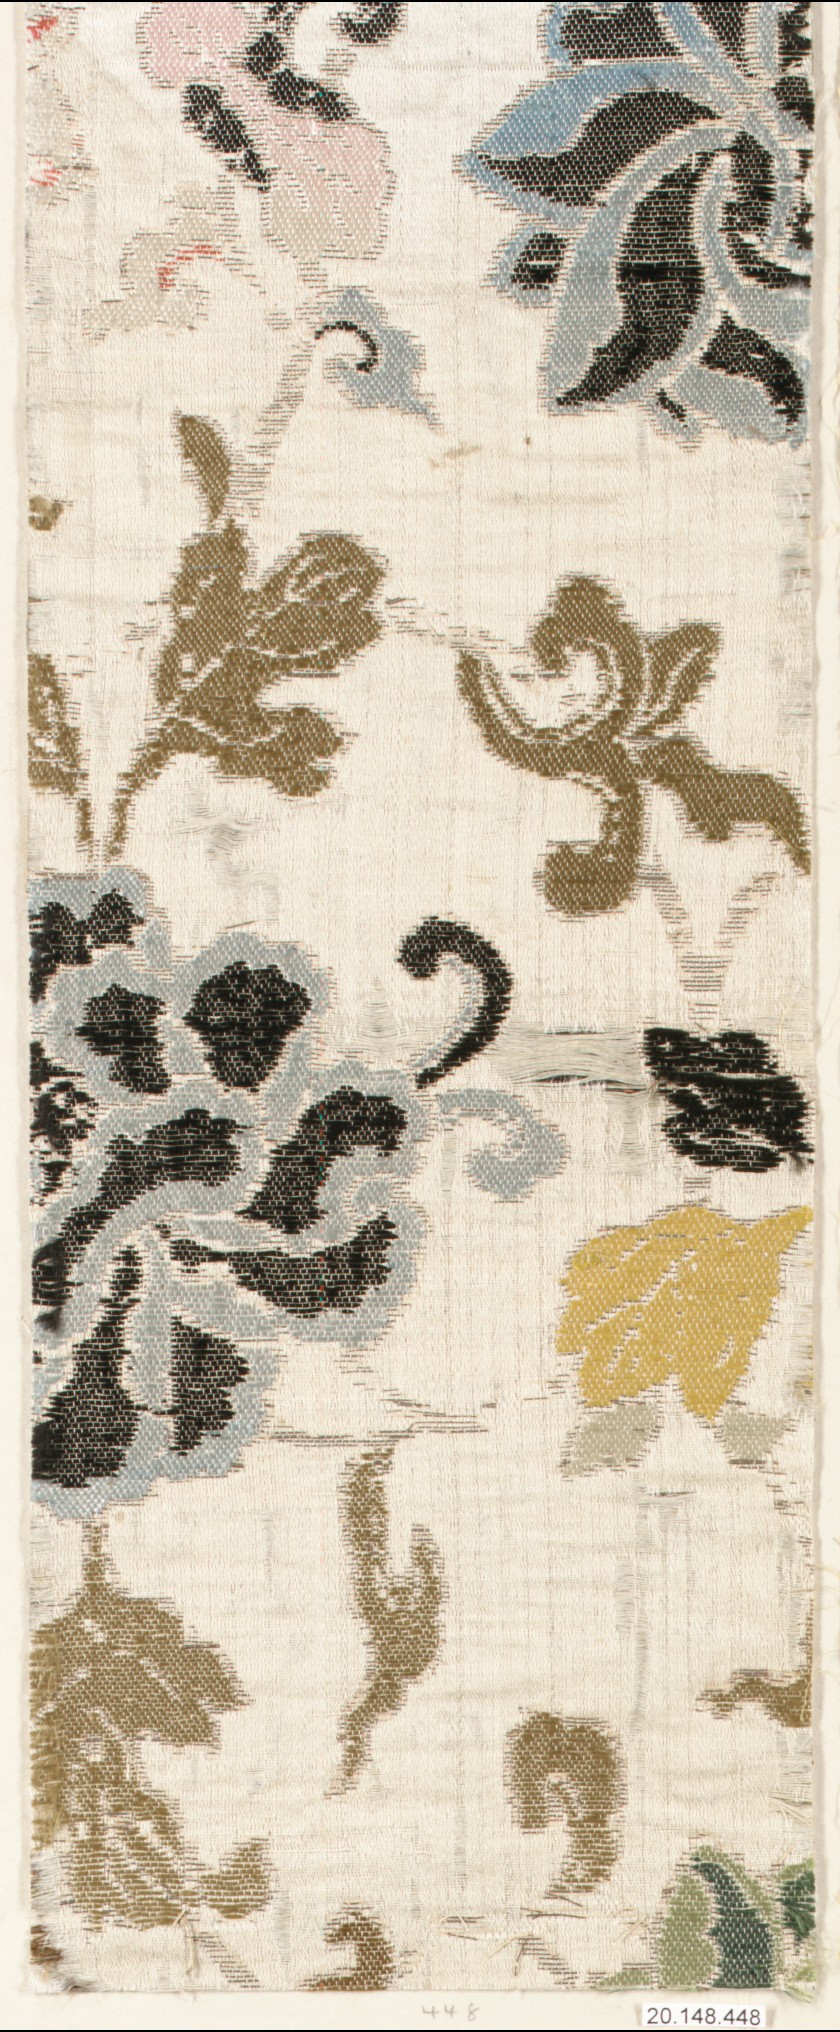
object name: piece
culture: chinese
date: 1601-1700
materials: silk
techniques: compound weave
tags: flowers